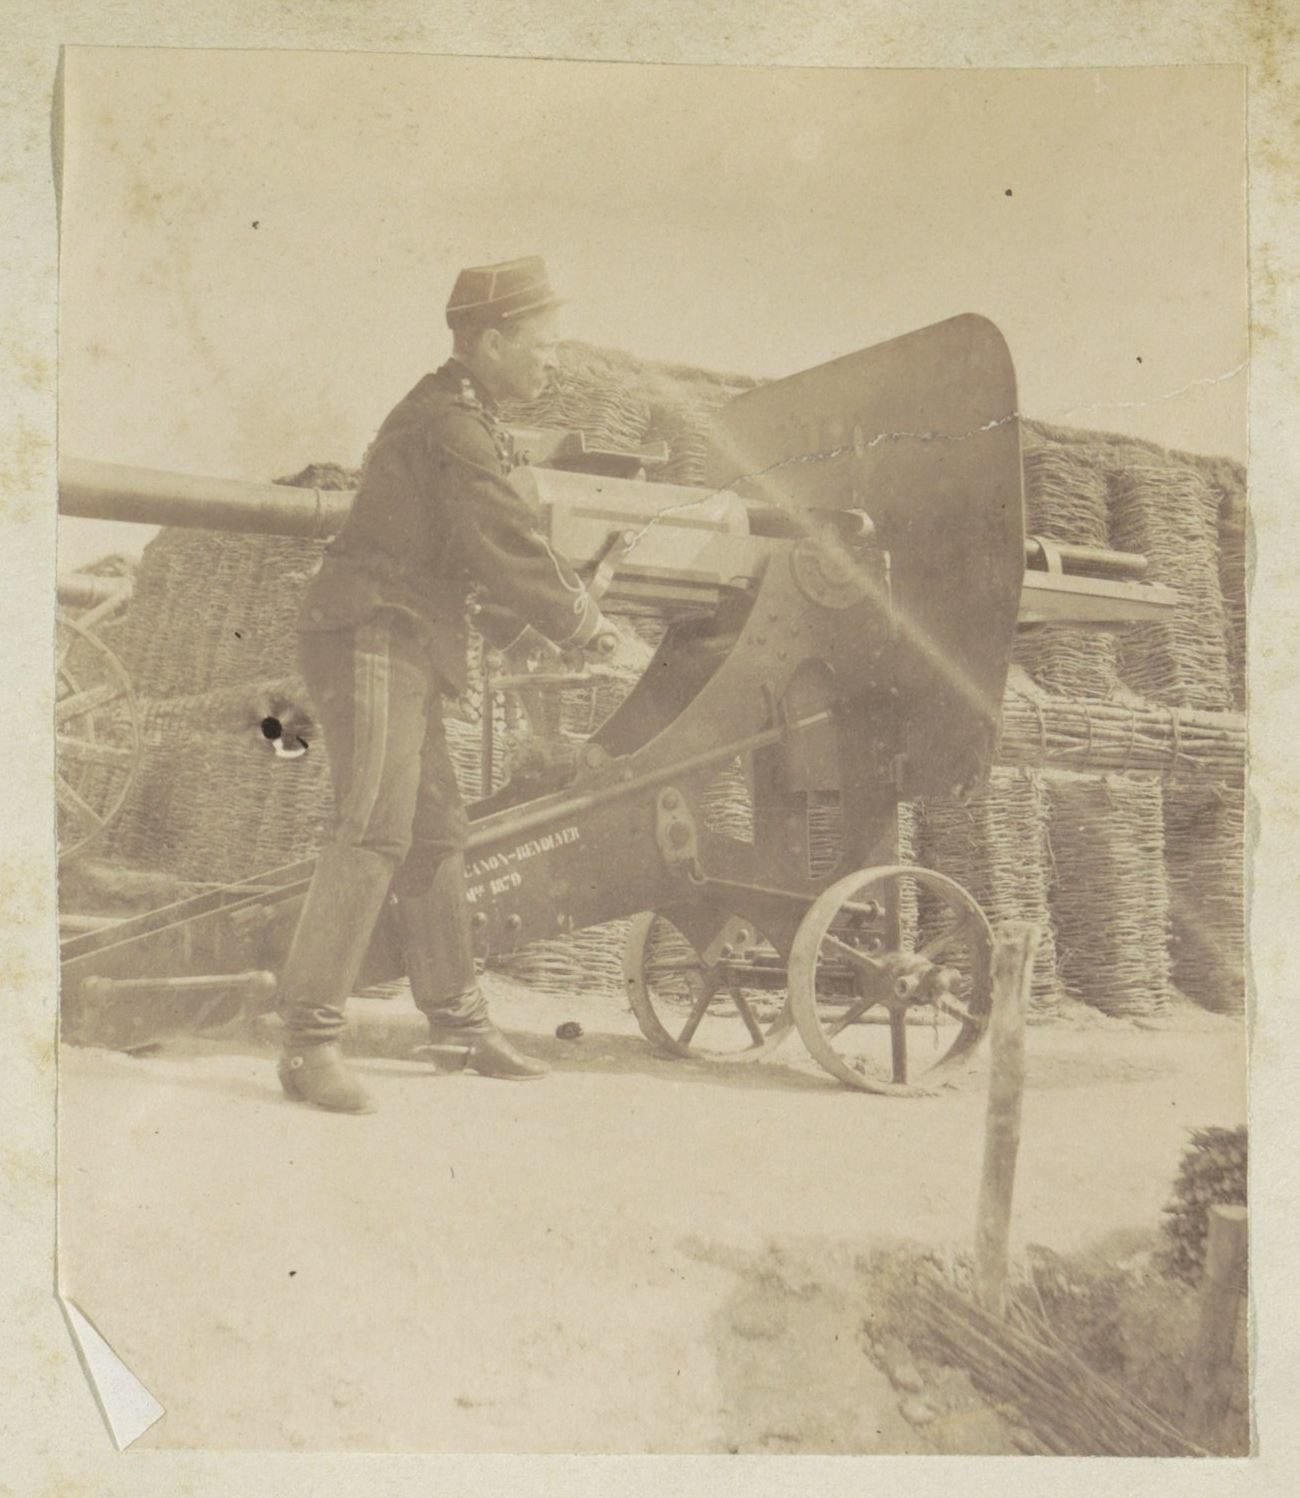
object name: photograph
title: Franse militair bij een licht kanon met opschrift 'canon-revolver 1879'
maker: Anonymous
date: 1885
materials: photographic support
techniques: albumen print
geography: france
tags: land forces (+ artillery), firearms: cannon (+ land forces), france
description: Onderdeel van Album van een Franse amateurfotograaf met opnames van familie, militairen, industrie, landschappen en bezienswaardigheden in Frankrijk.